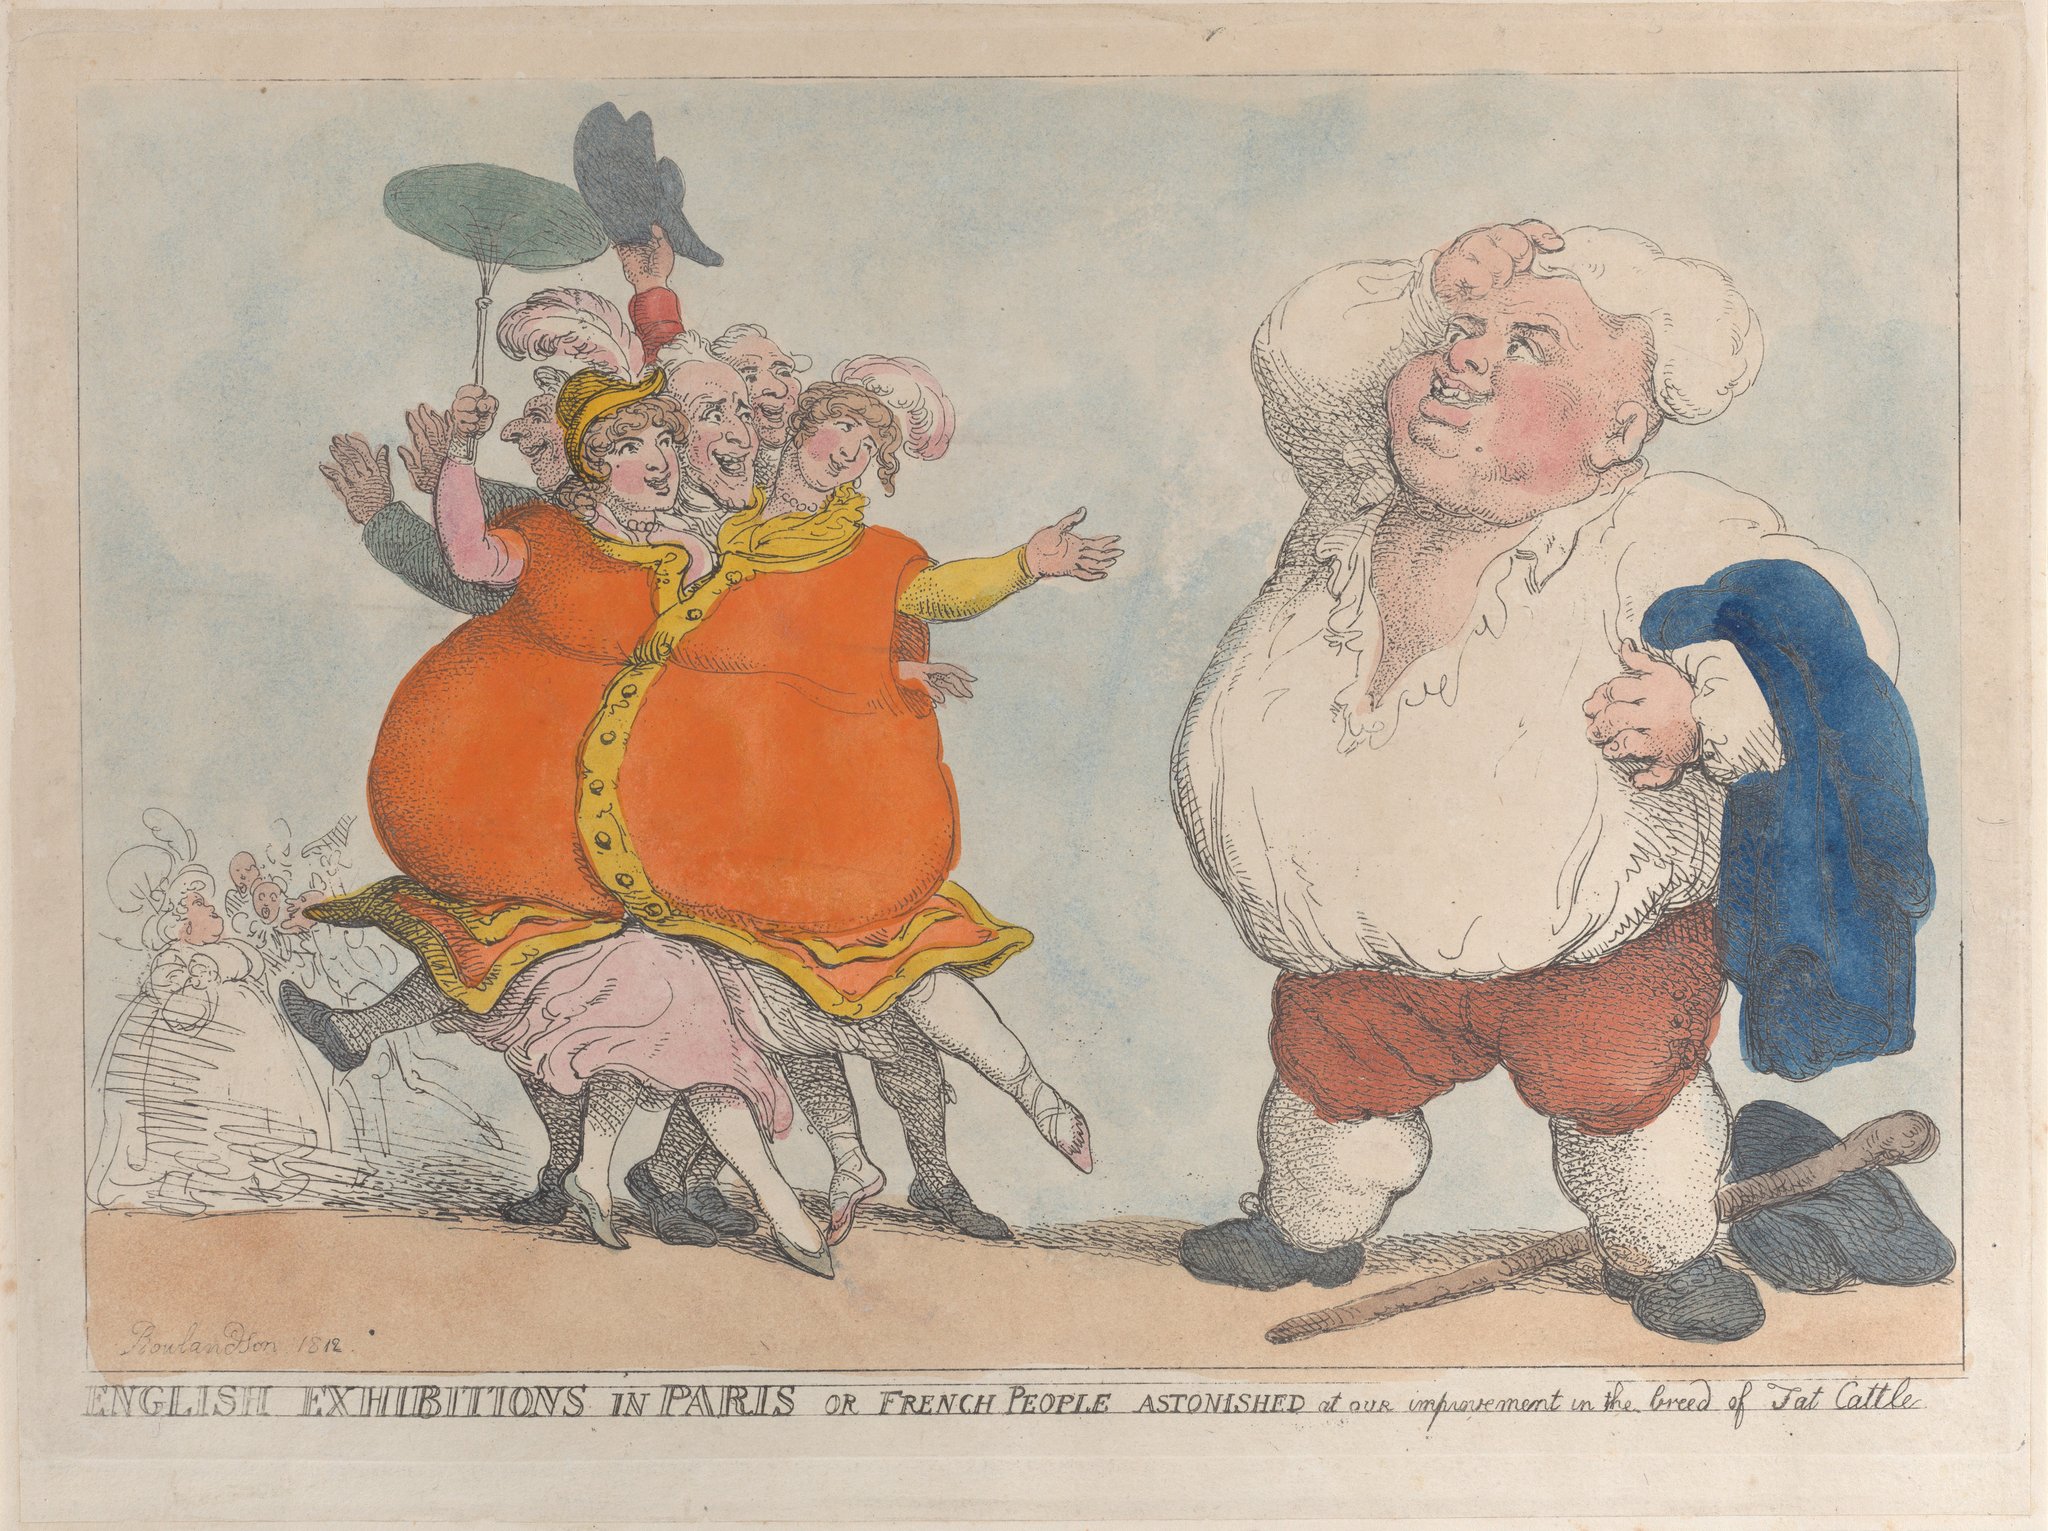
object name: print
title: English Exhibitions in Paris or French People Astonished at Our Improvement in the Breed of Fat Cattle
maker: thomas rowlandson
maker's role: artist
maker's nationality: british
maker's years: 1757-1827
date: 1812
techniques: etching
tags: satire,men,women